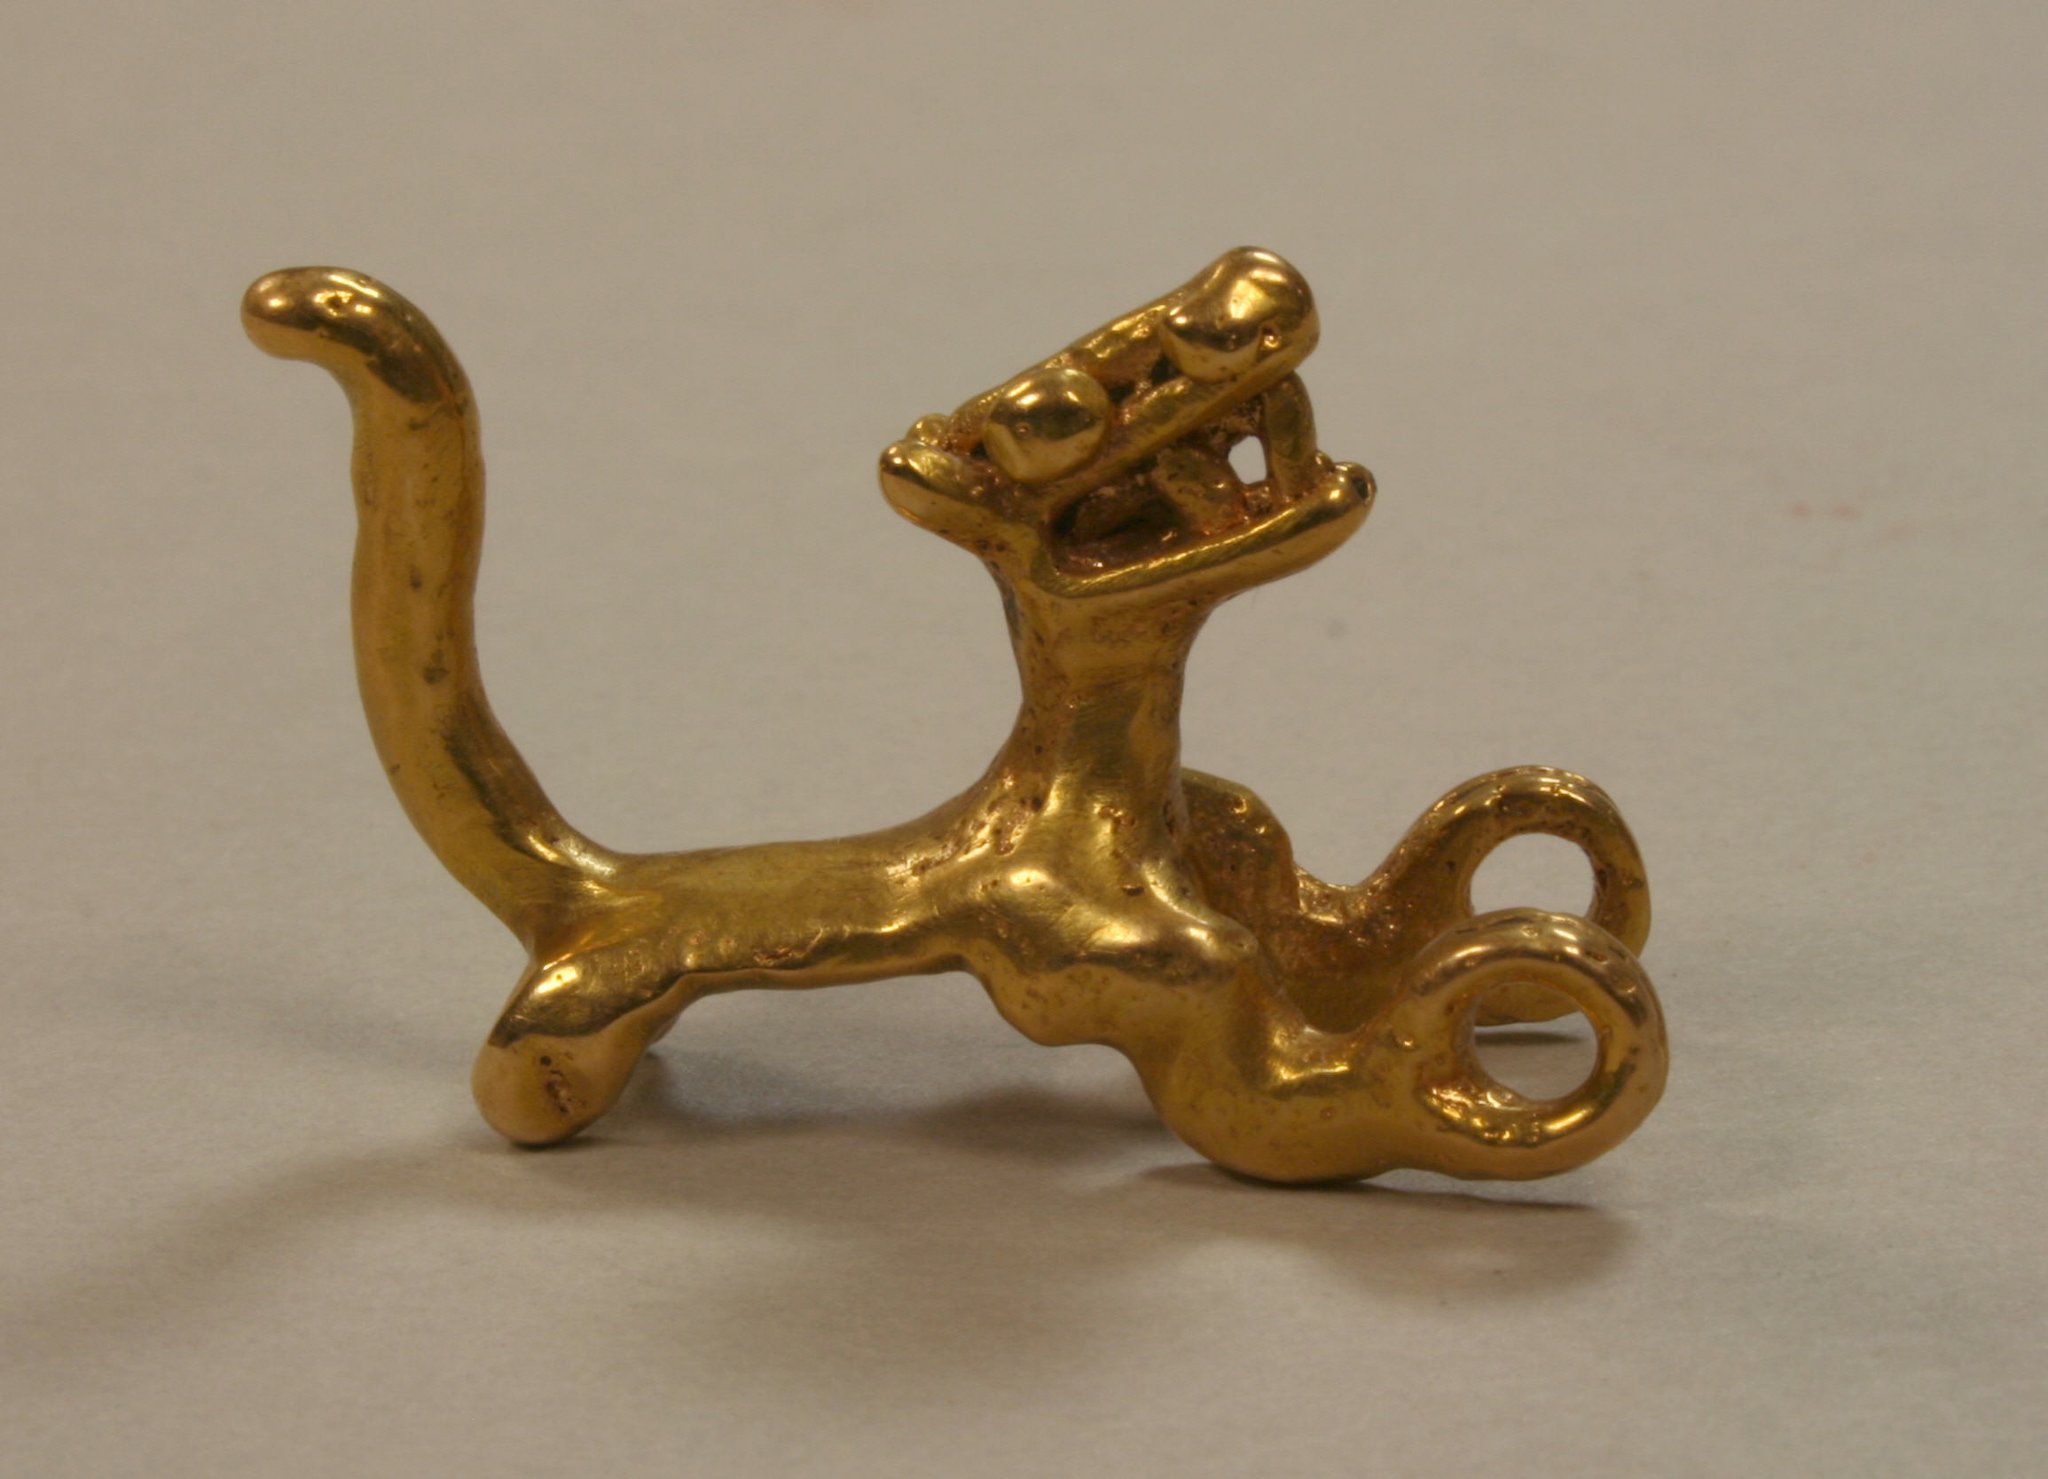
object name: ornament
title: Feline Ornament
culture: costa rican or panamanian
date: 1001-1600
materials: gold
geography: costa rica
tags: cats